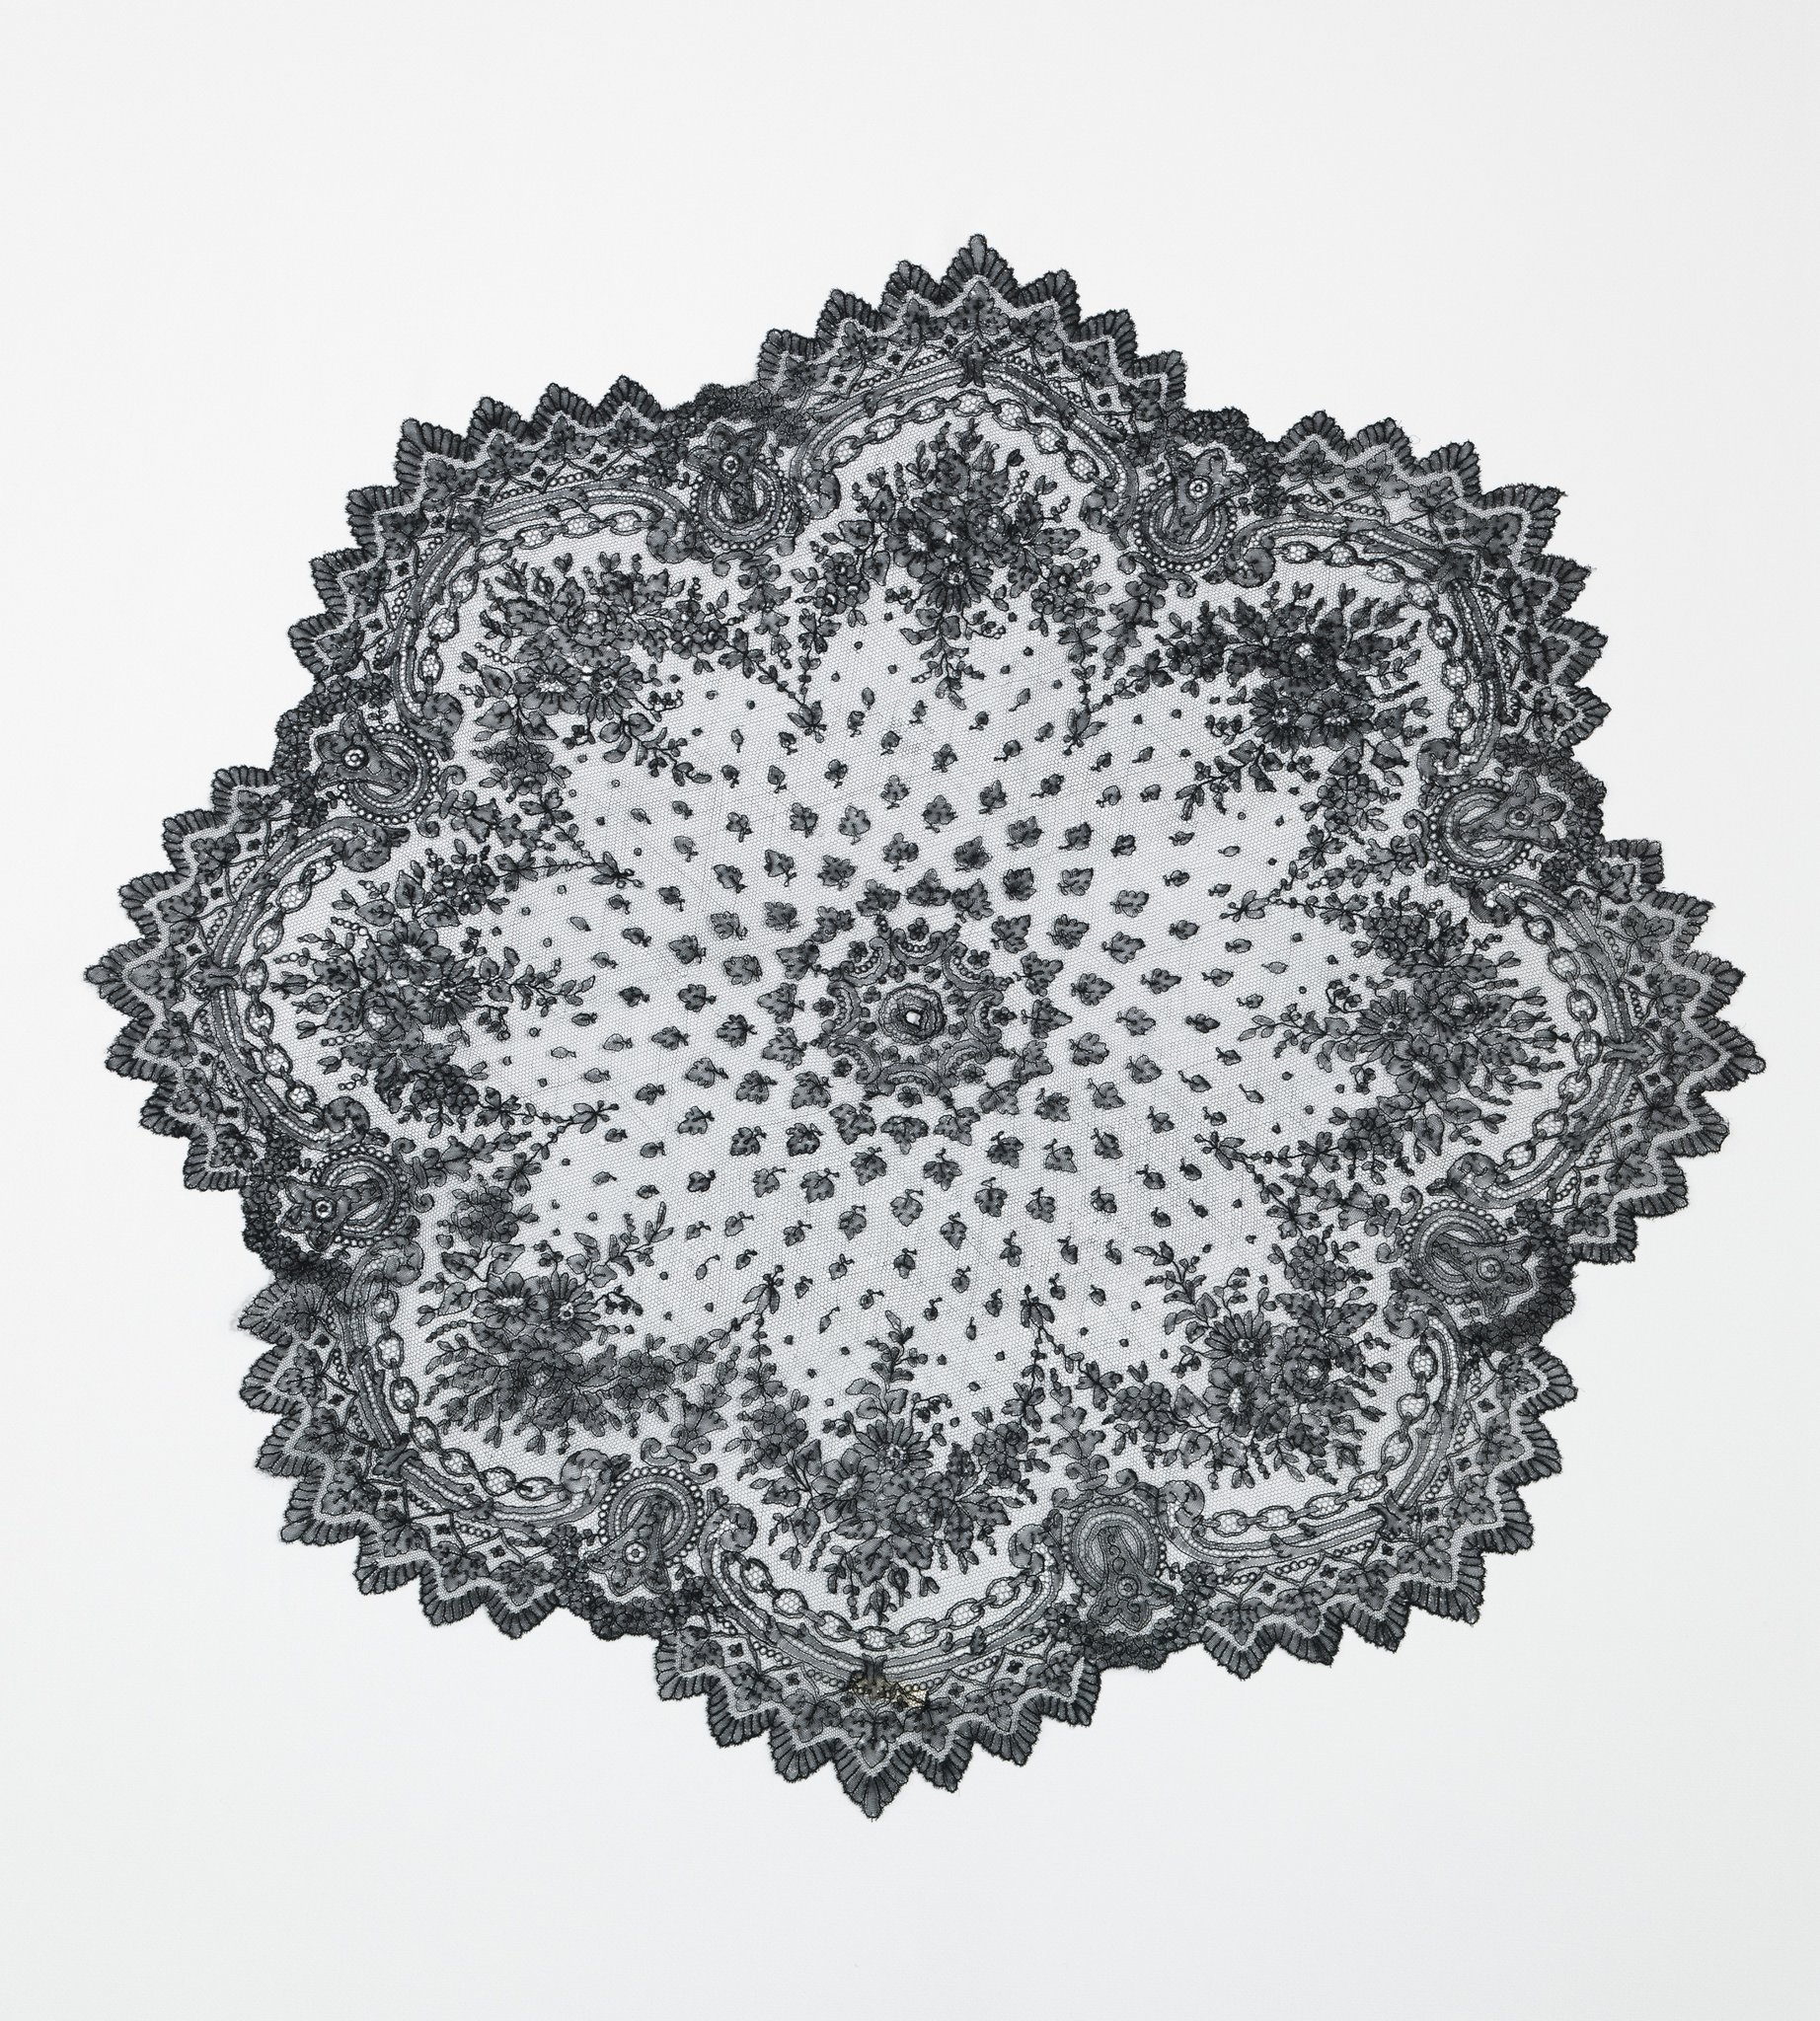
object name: parasol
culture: french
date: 1880-1889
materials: silk